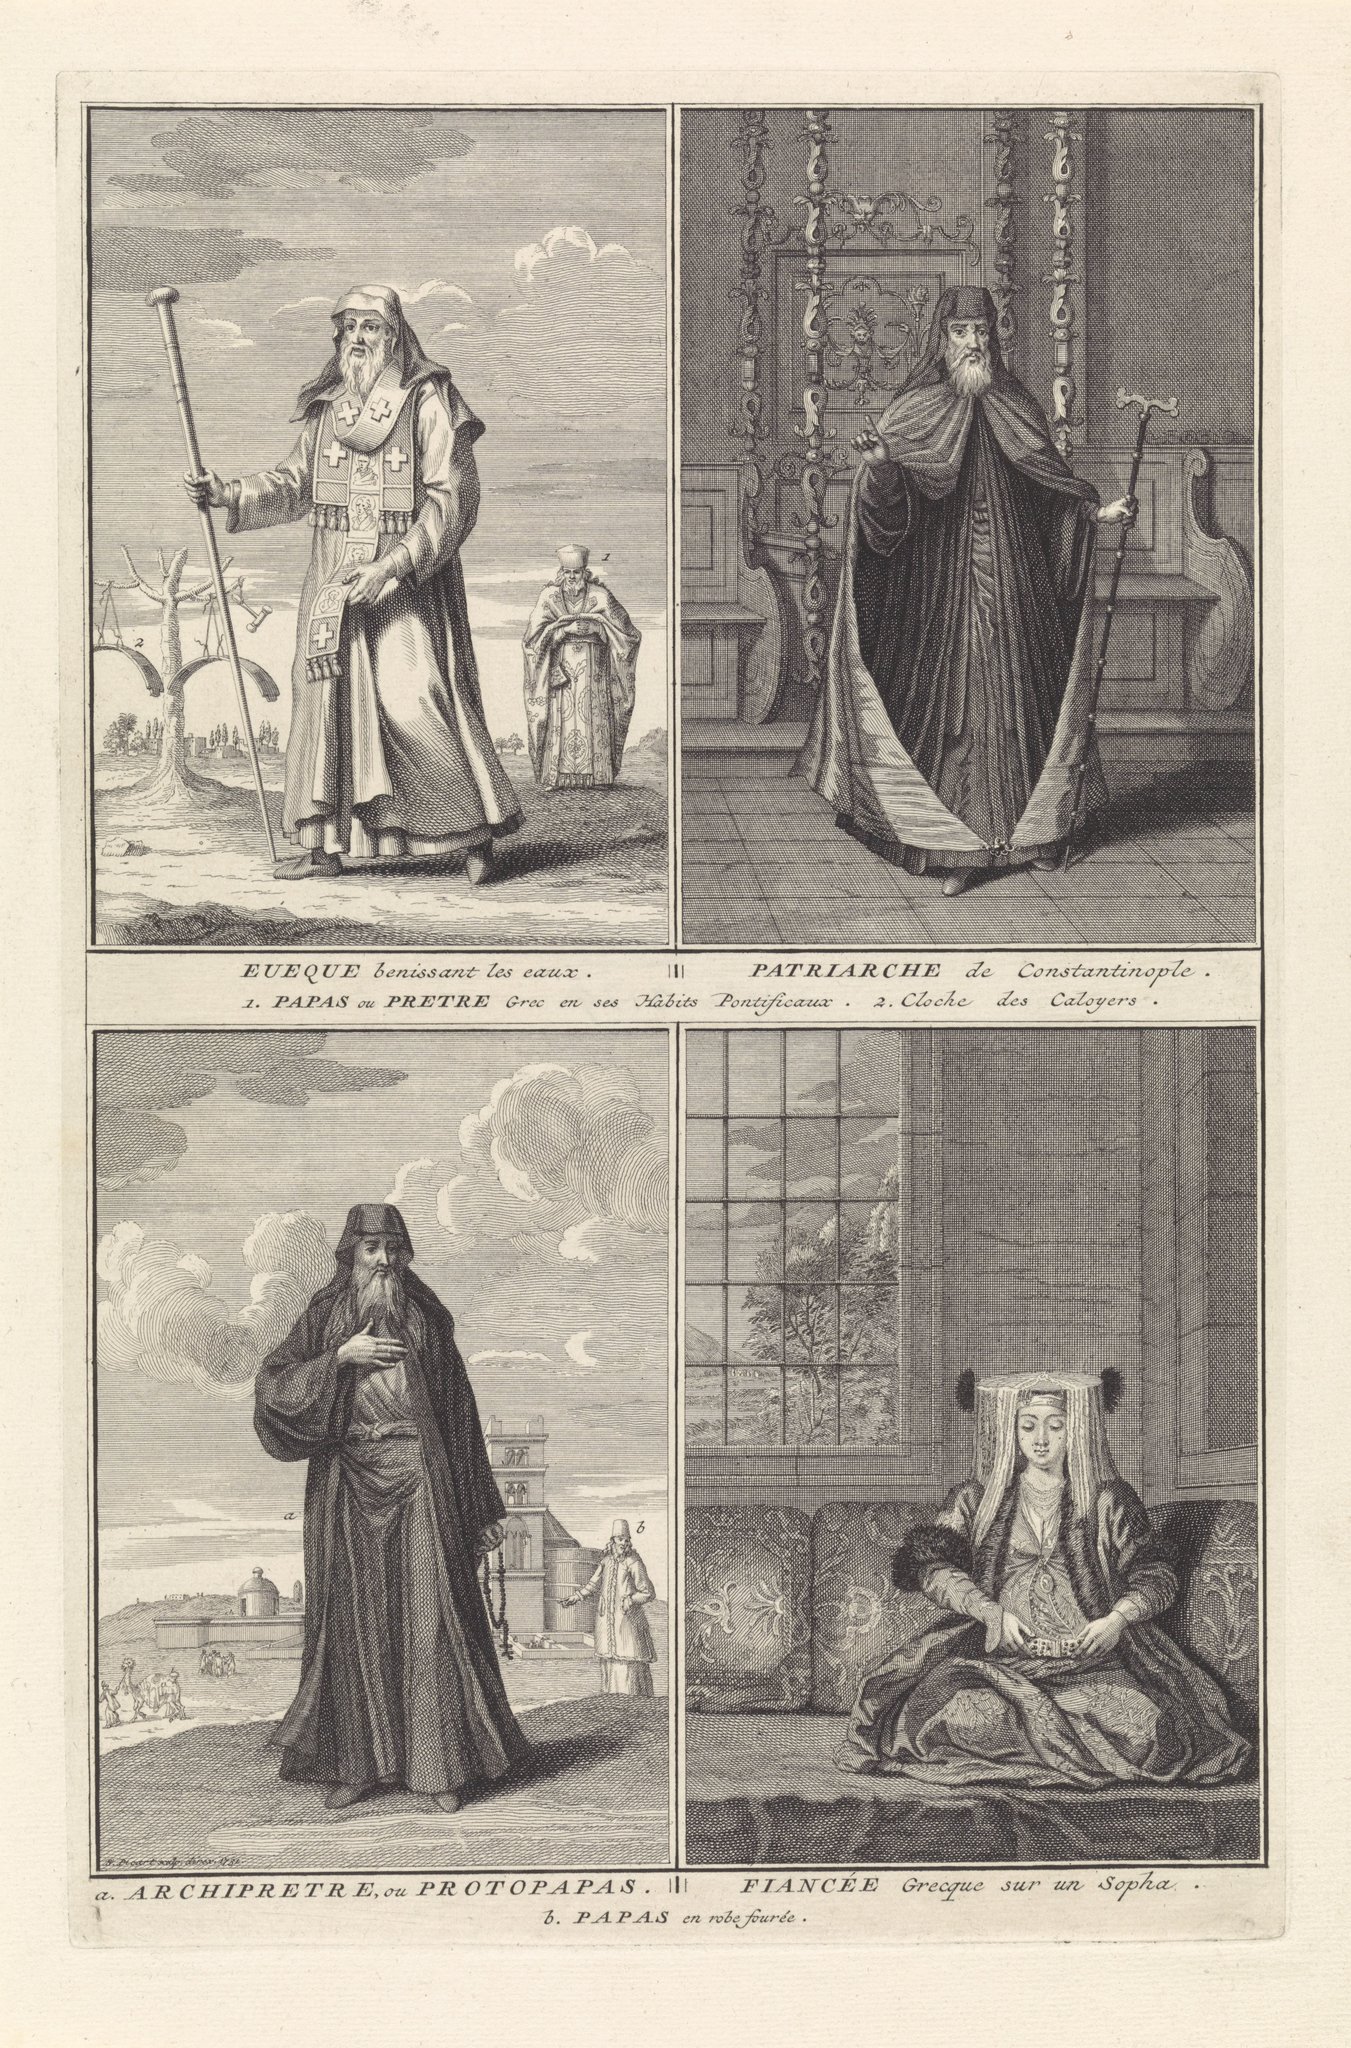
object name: book illustration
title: Eveque benissant les eaux (...)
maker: bernard picart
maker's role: draughtsman, print maker, publisher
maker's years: 1673-1733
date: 1731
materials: paper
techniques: engraving, etching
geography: amsterdam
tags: priest (eastern, greek and russian orthodox)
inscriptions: collector's mark: Lugt 2228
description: Blad met vier voorstellingen van drie geestelijken in de Grieks-orthodoxe kerk en een Griekse bruid. Linksboven: Een bisschop zegent het water. Op de achtergrond een priester. Rechtsboven: De patriach van Constantinopel. Linksonder: Een aartspriester of zogenaamde protopapas. Rechtsonder: Op een sofa zit een aanstaande bruid, gekleed in Griekse kleding.